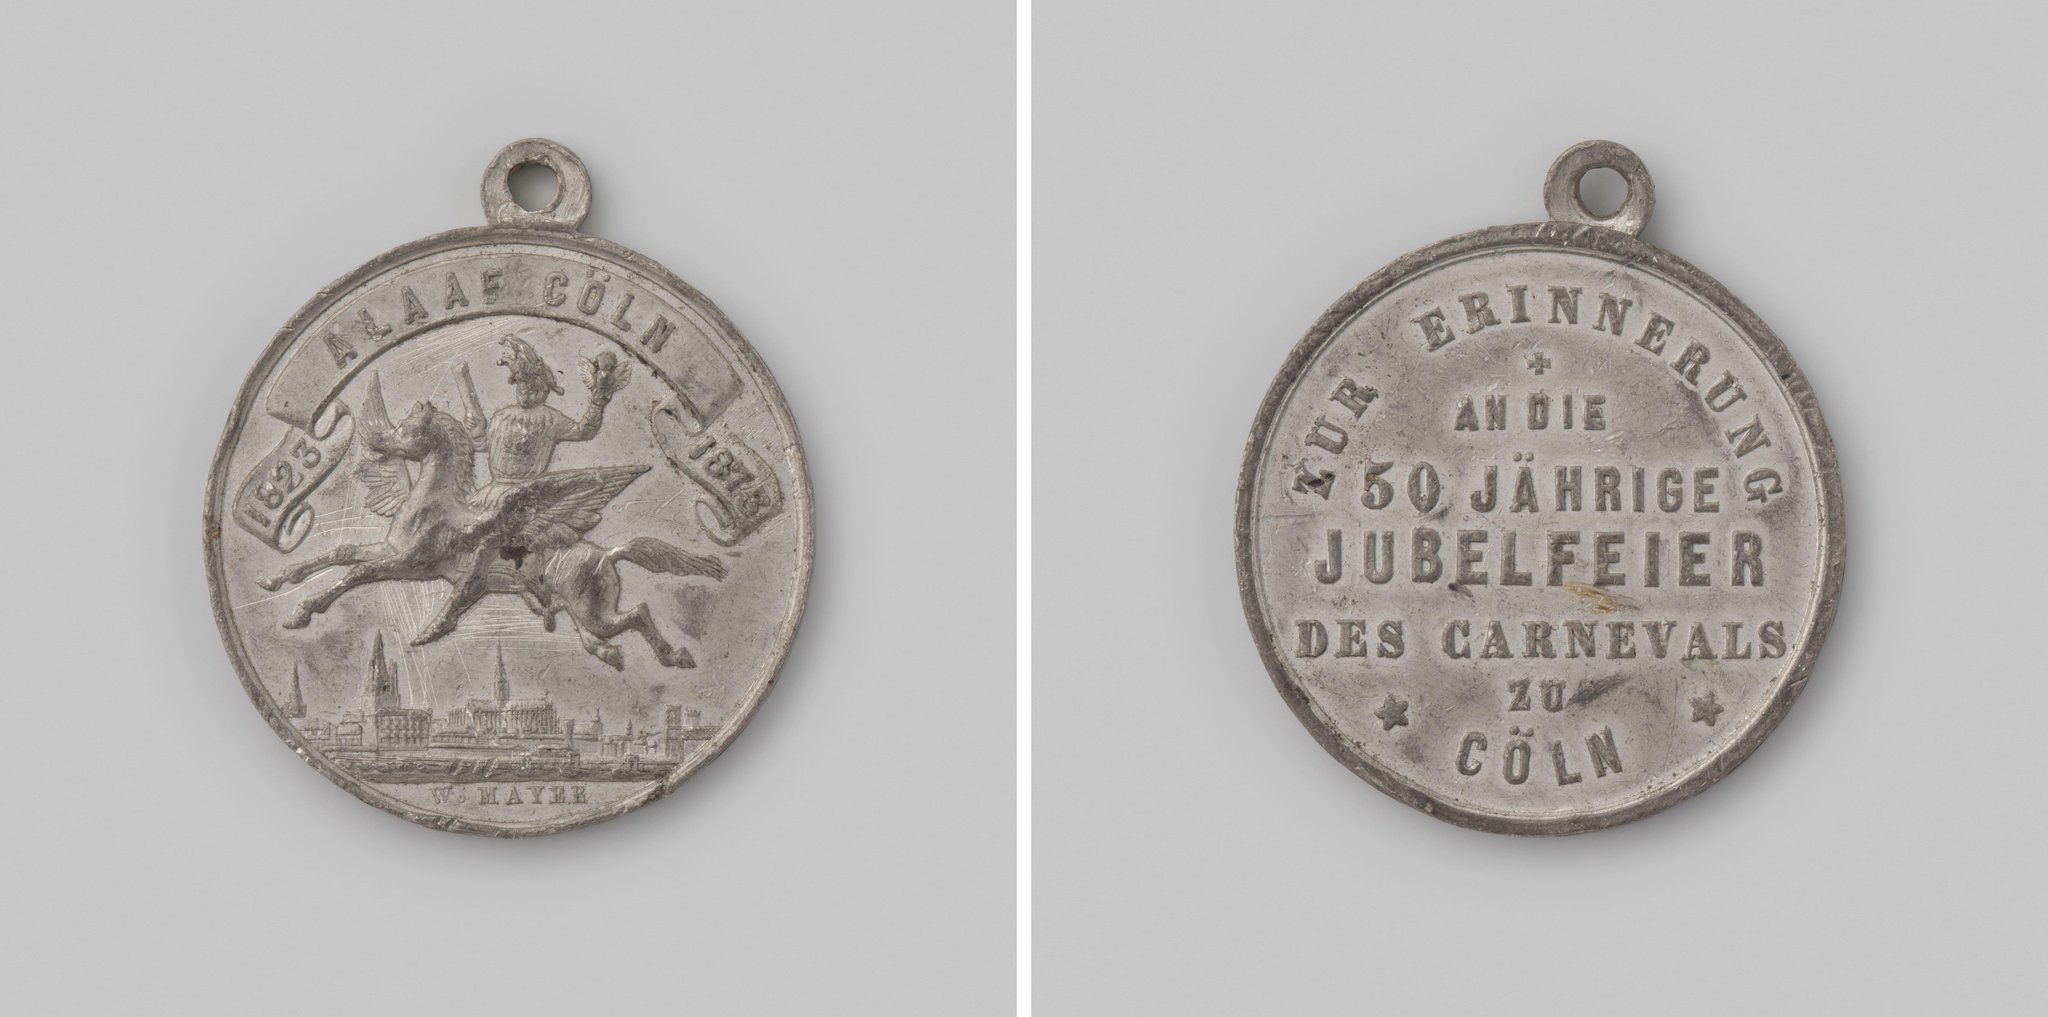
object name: history medal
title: Vijftigjarig Jubelfeest van het Carnaval te Keulen 1873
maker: w. mayer (i)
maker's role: fotograaf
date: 1873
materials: tin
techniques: striking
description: Tinnen penning met draagoog, op de voorzijde Prins Carnaval op een gevleugeld paard boven Keulen met bovenaan een banderol, op de keerzijde zeven regels tekst.